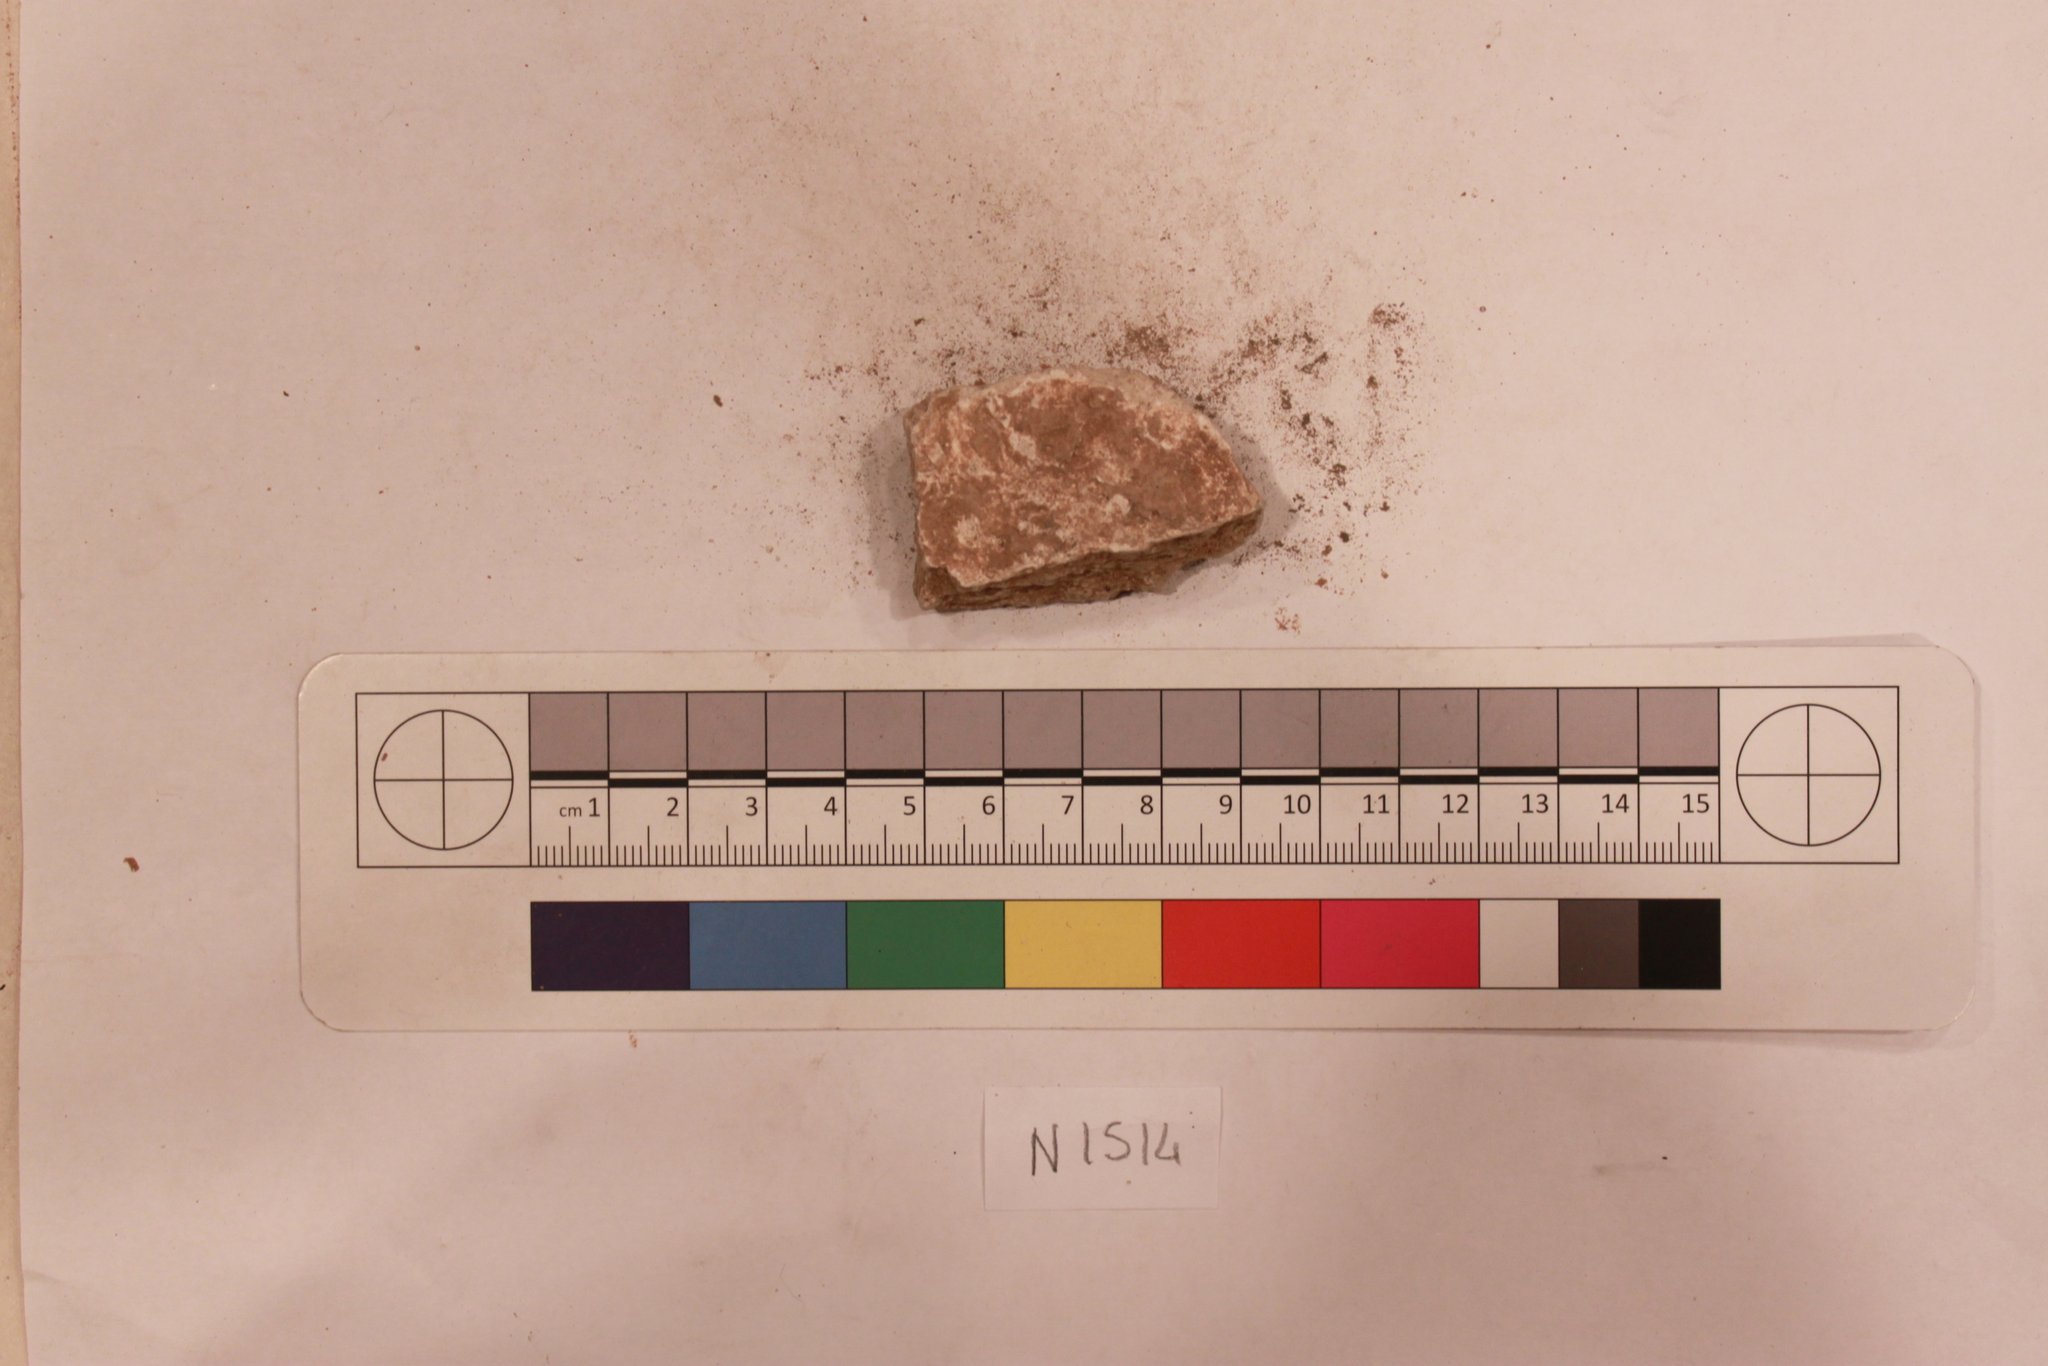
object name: fragment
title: Stucco Fragment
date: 701-1200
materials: plaster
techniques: carving, painting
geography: iran